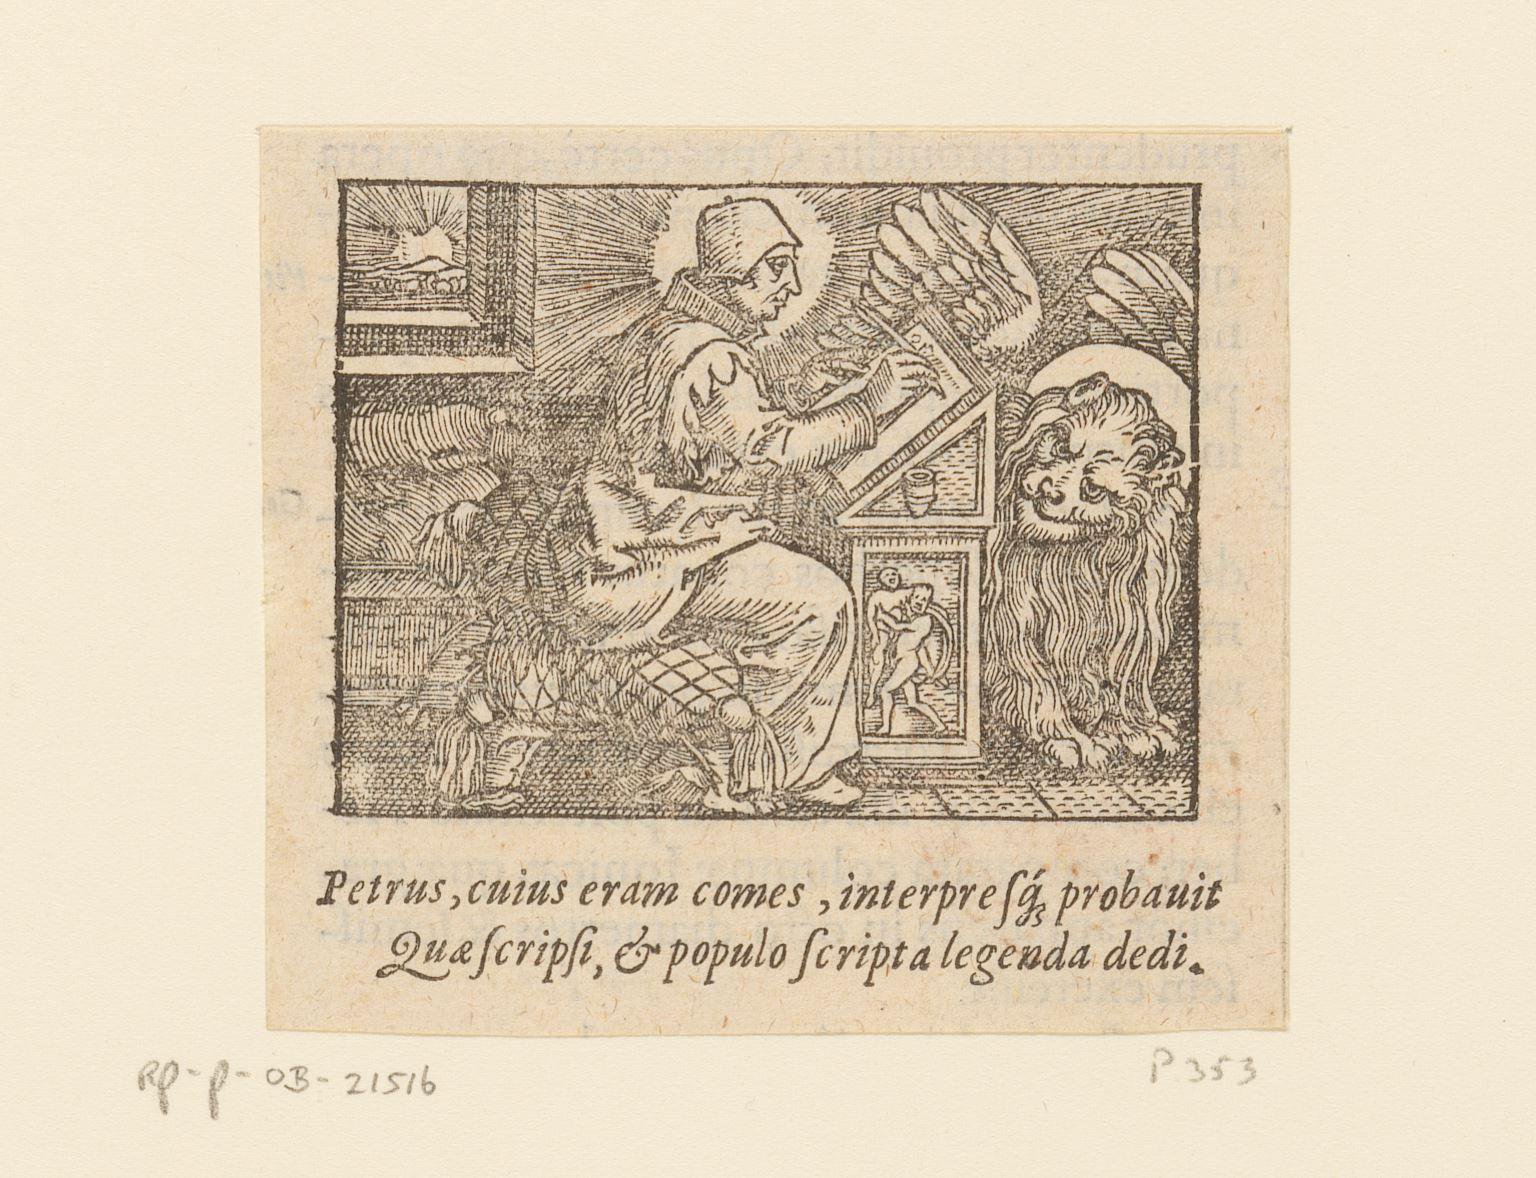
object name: print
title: Evangelist Marcus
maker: Anonymous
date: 1534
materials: paper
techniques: woodcut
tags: mark (marcus) the evangelist, and bishop of alexandria; possible attributes: book, (winged) lion, pen and inkhorn, scroll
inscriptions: collector's mark: Lugt 240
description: Prent afkomstig uit een onbekende publicatie.